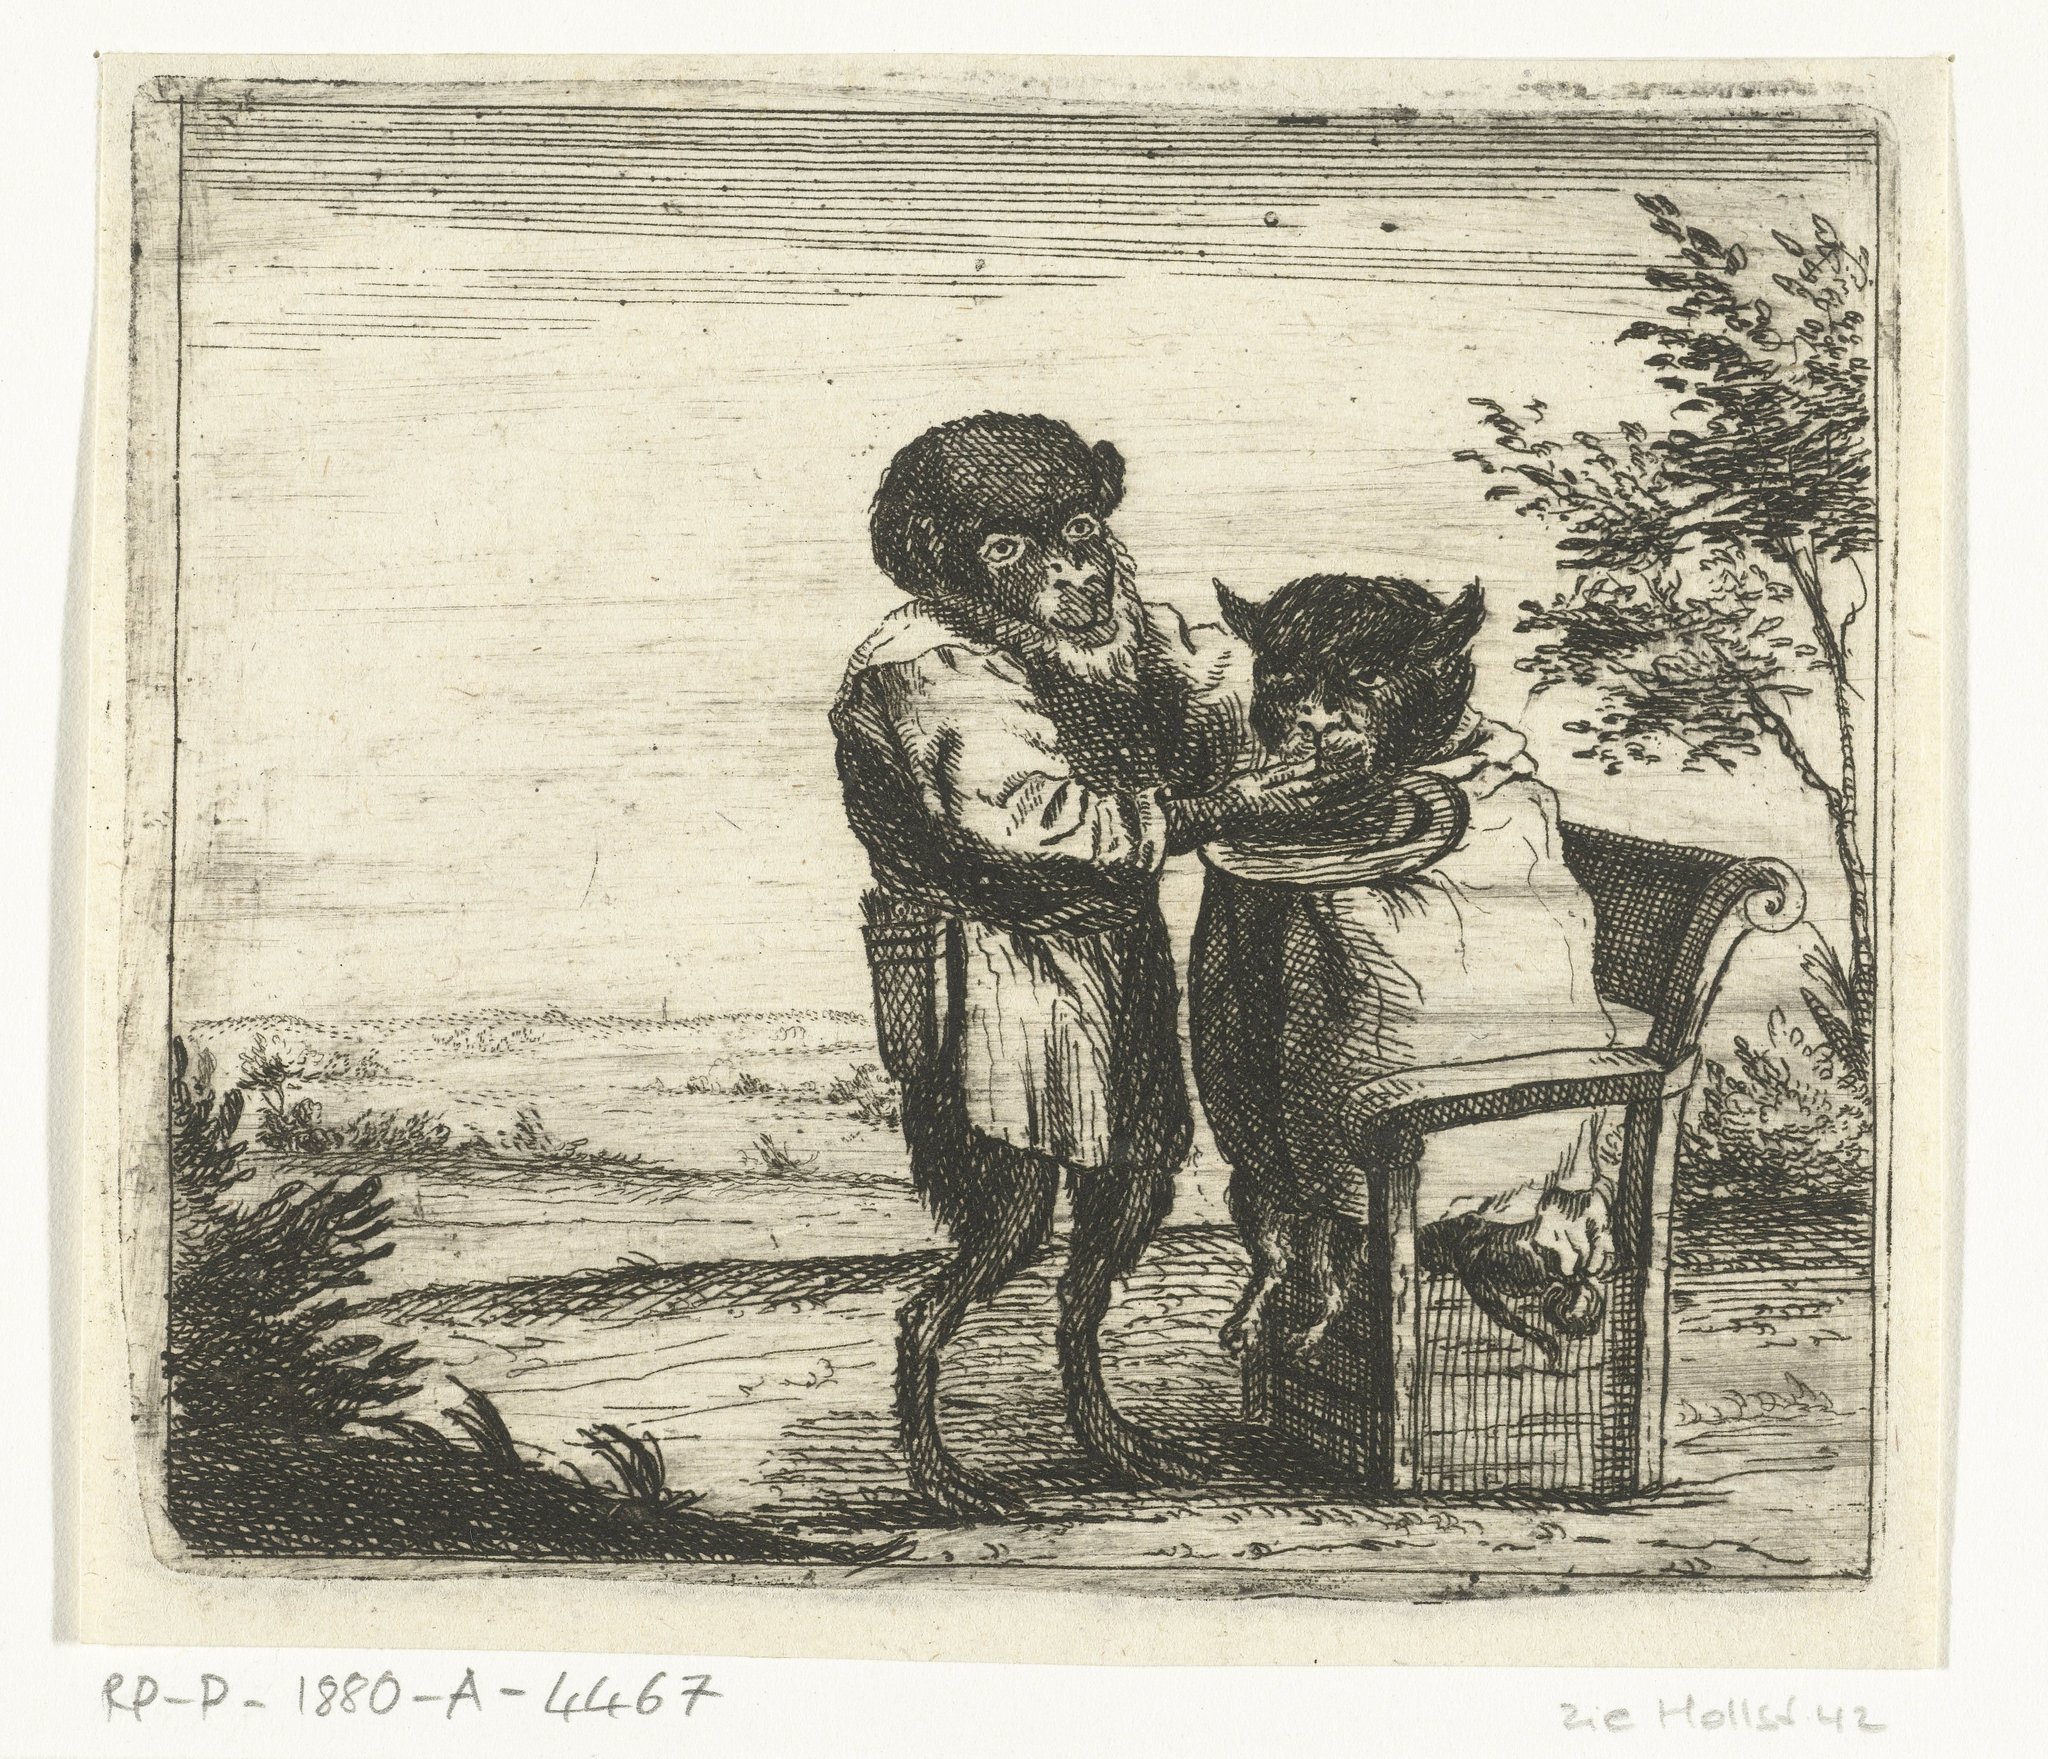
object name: print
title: Een aap scheert een kat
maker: Anonymous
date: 1635-1668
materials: paper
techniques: etching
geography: southern netherlands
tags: monkeys, apes, animals acting as human beings, barber, barbershop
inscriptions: collector's mark: Lugt 2228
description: Singerie. Een kat zit buiten op een rietenstoel, een aap mengt de scheerzeep en scheert haar.